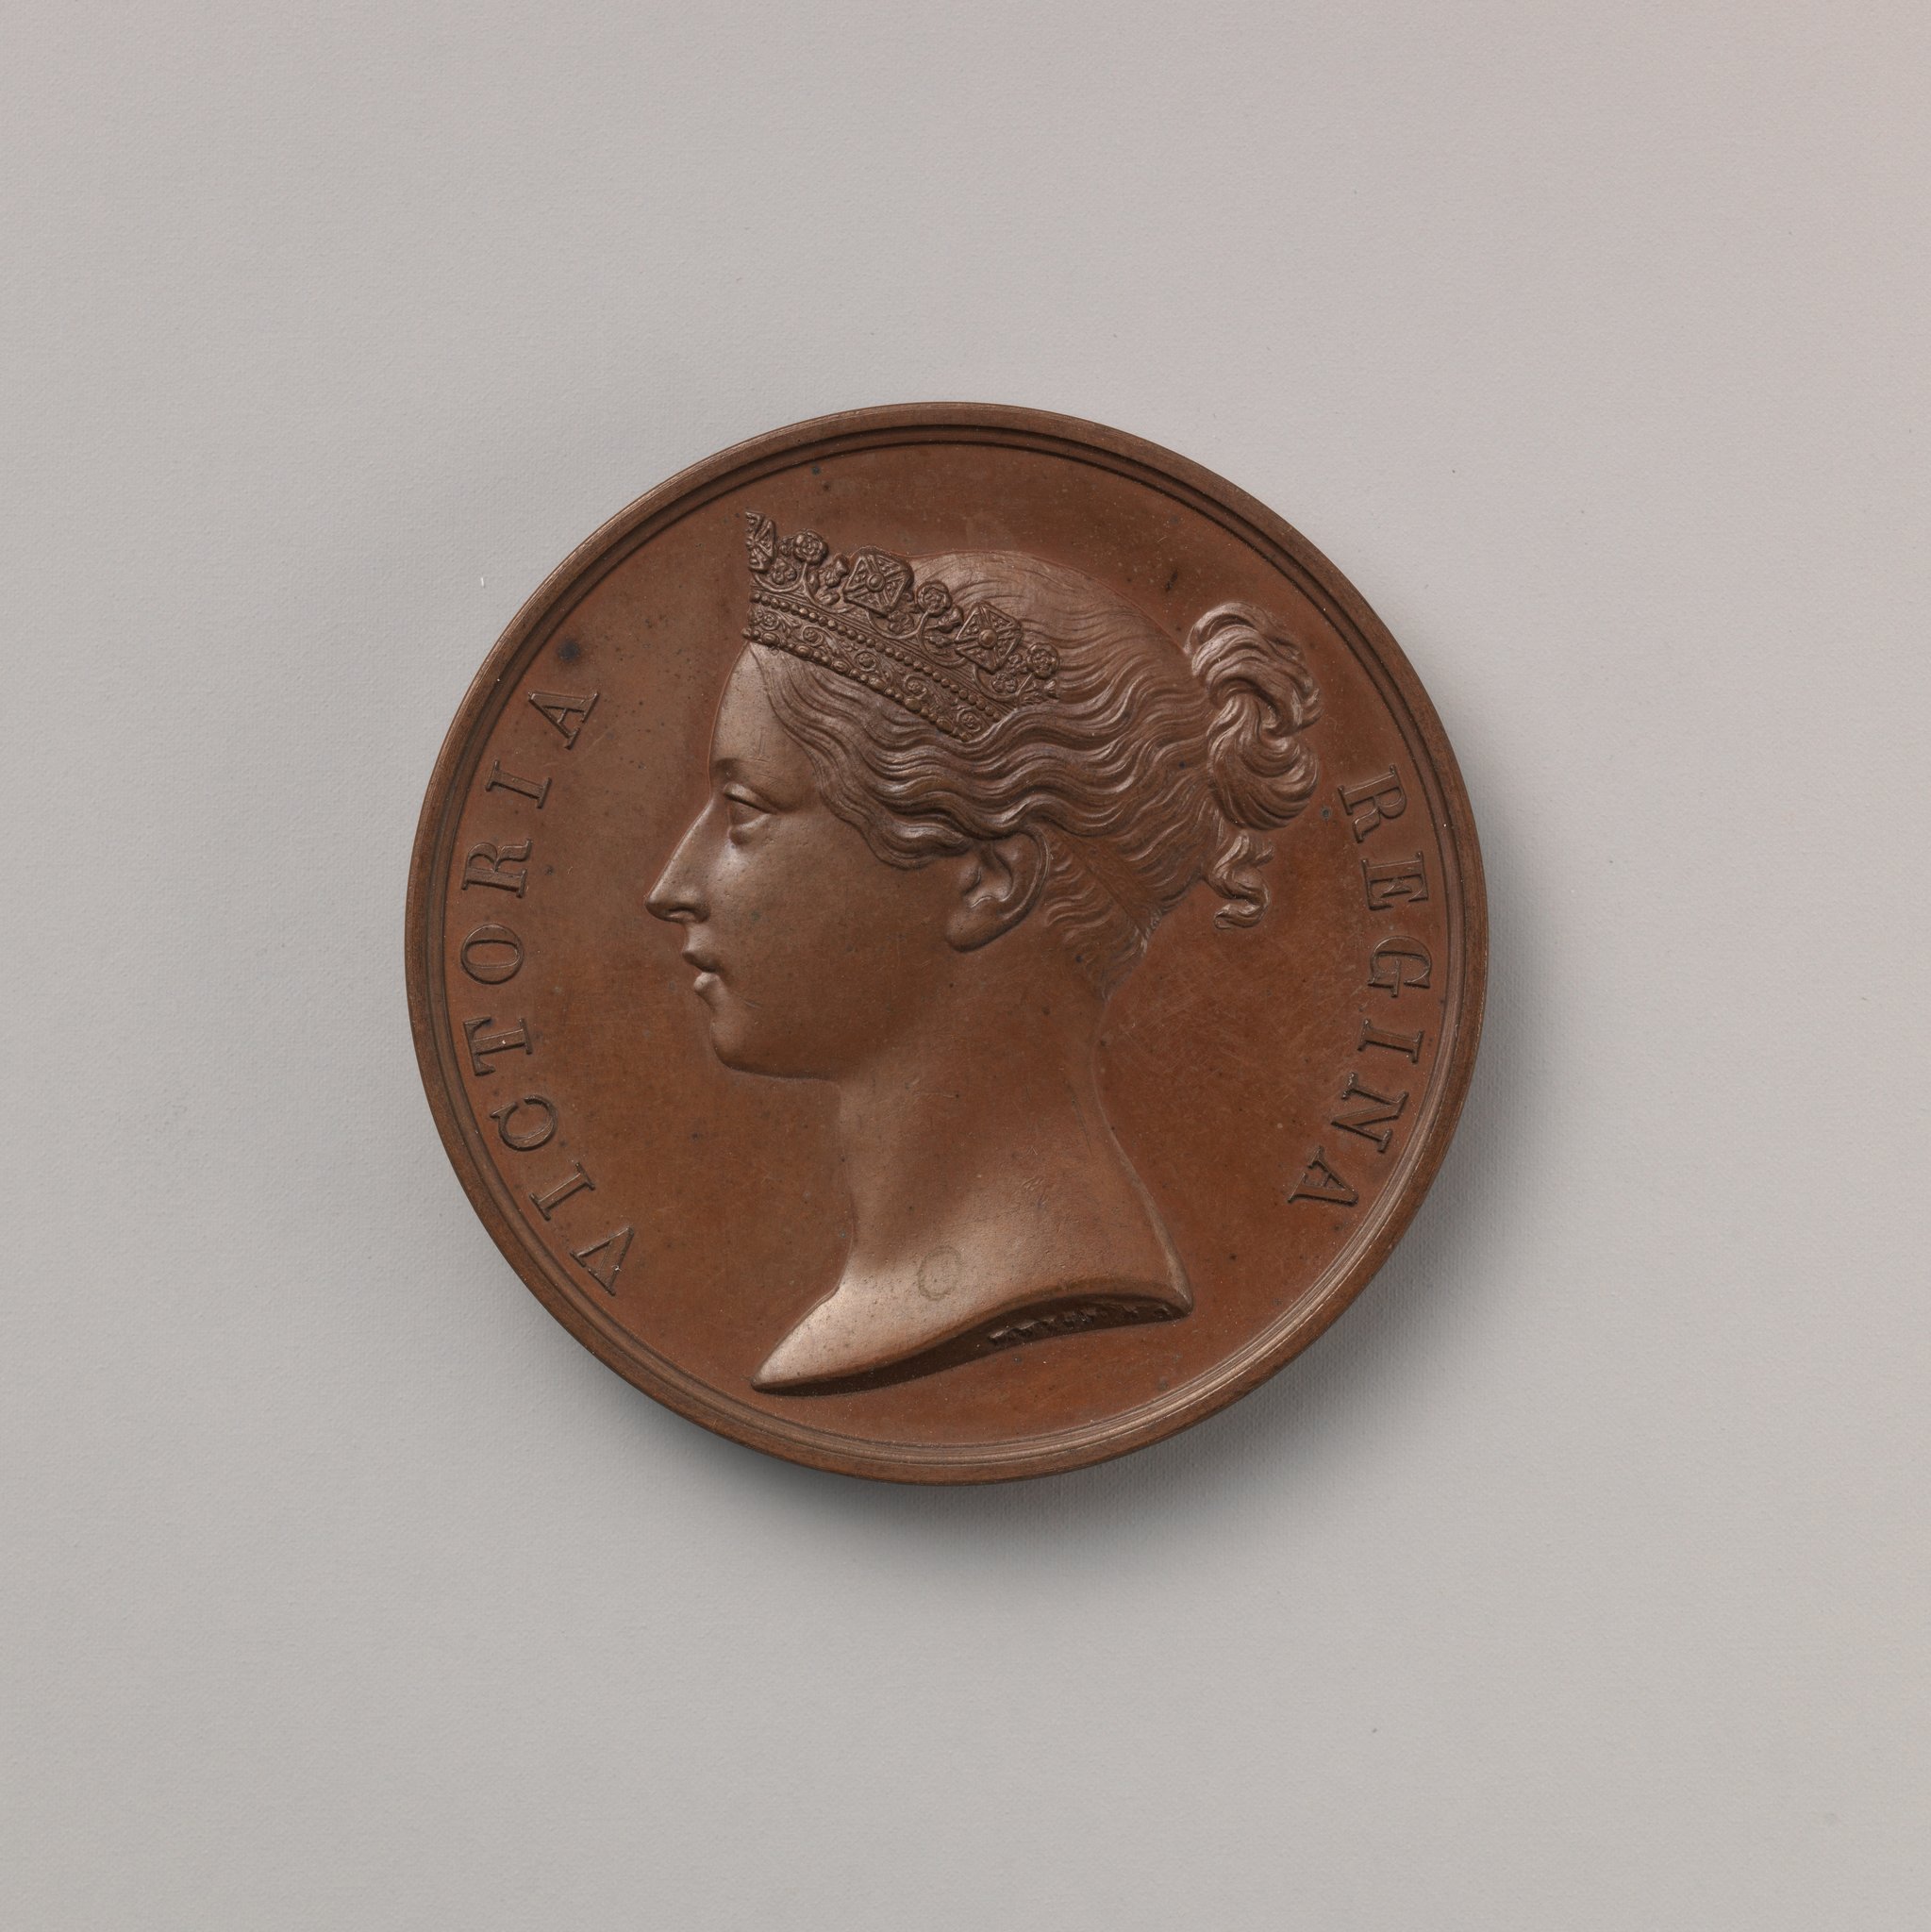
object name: medal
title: The Scinde Medal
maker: william wyon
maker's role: artist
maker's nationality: british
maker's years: 1795-1851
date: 1843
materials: bronze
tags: profiles,women